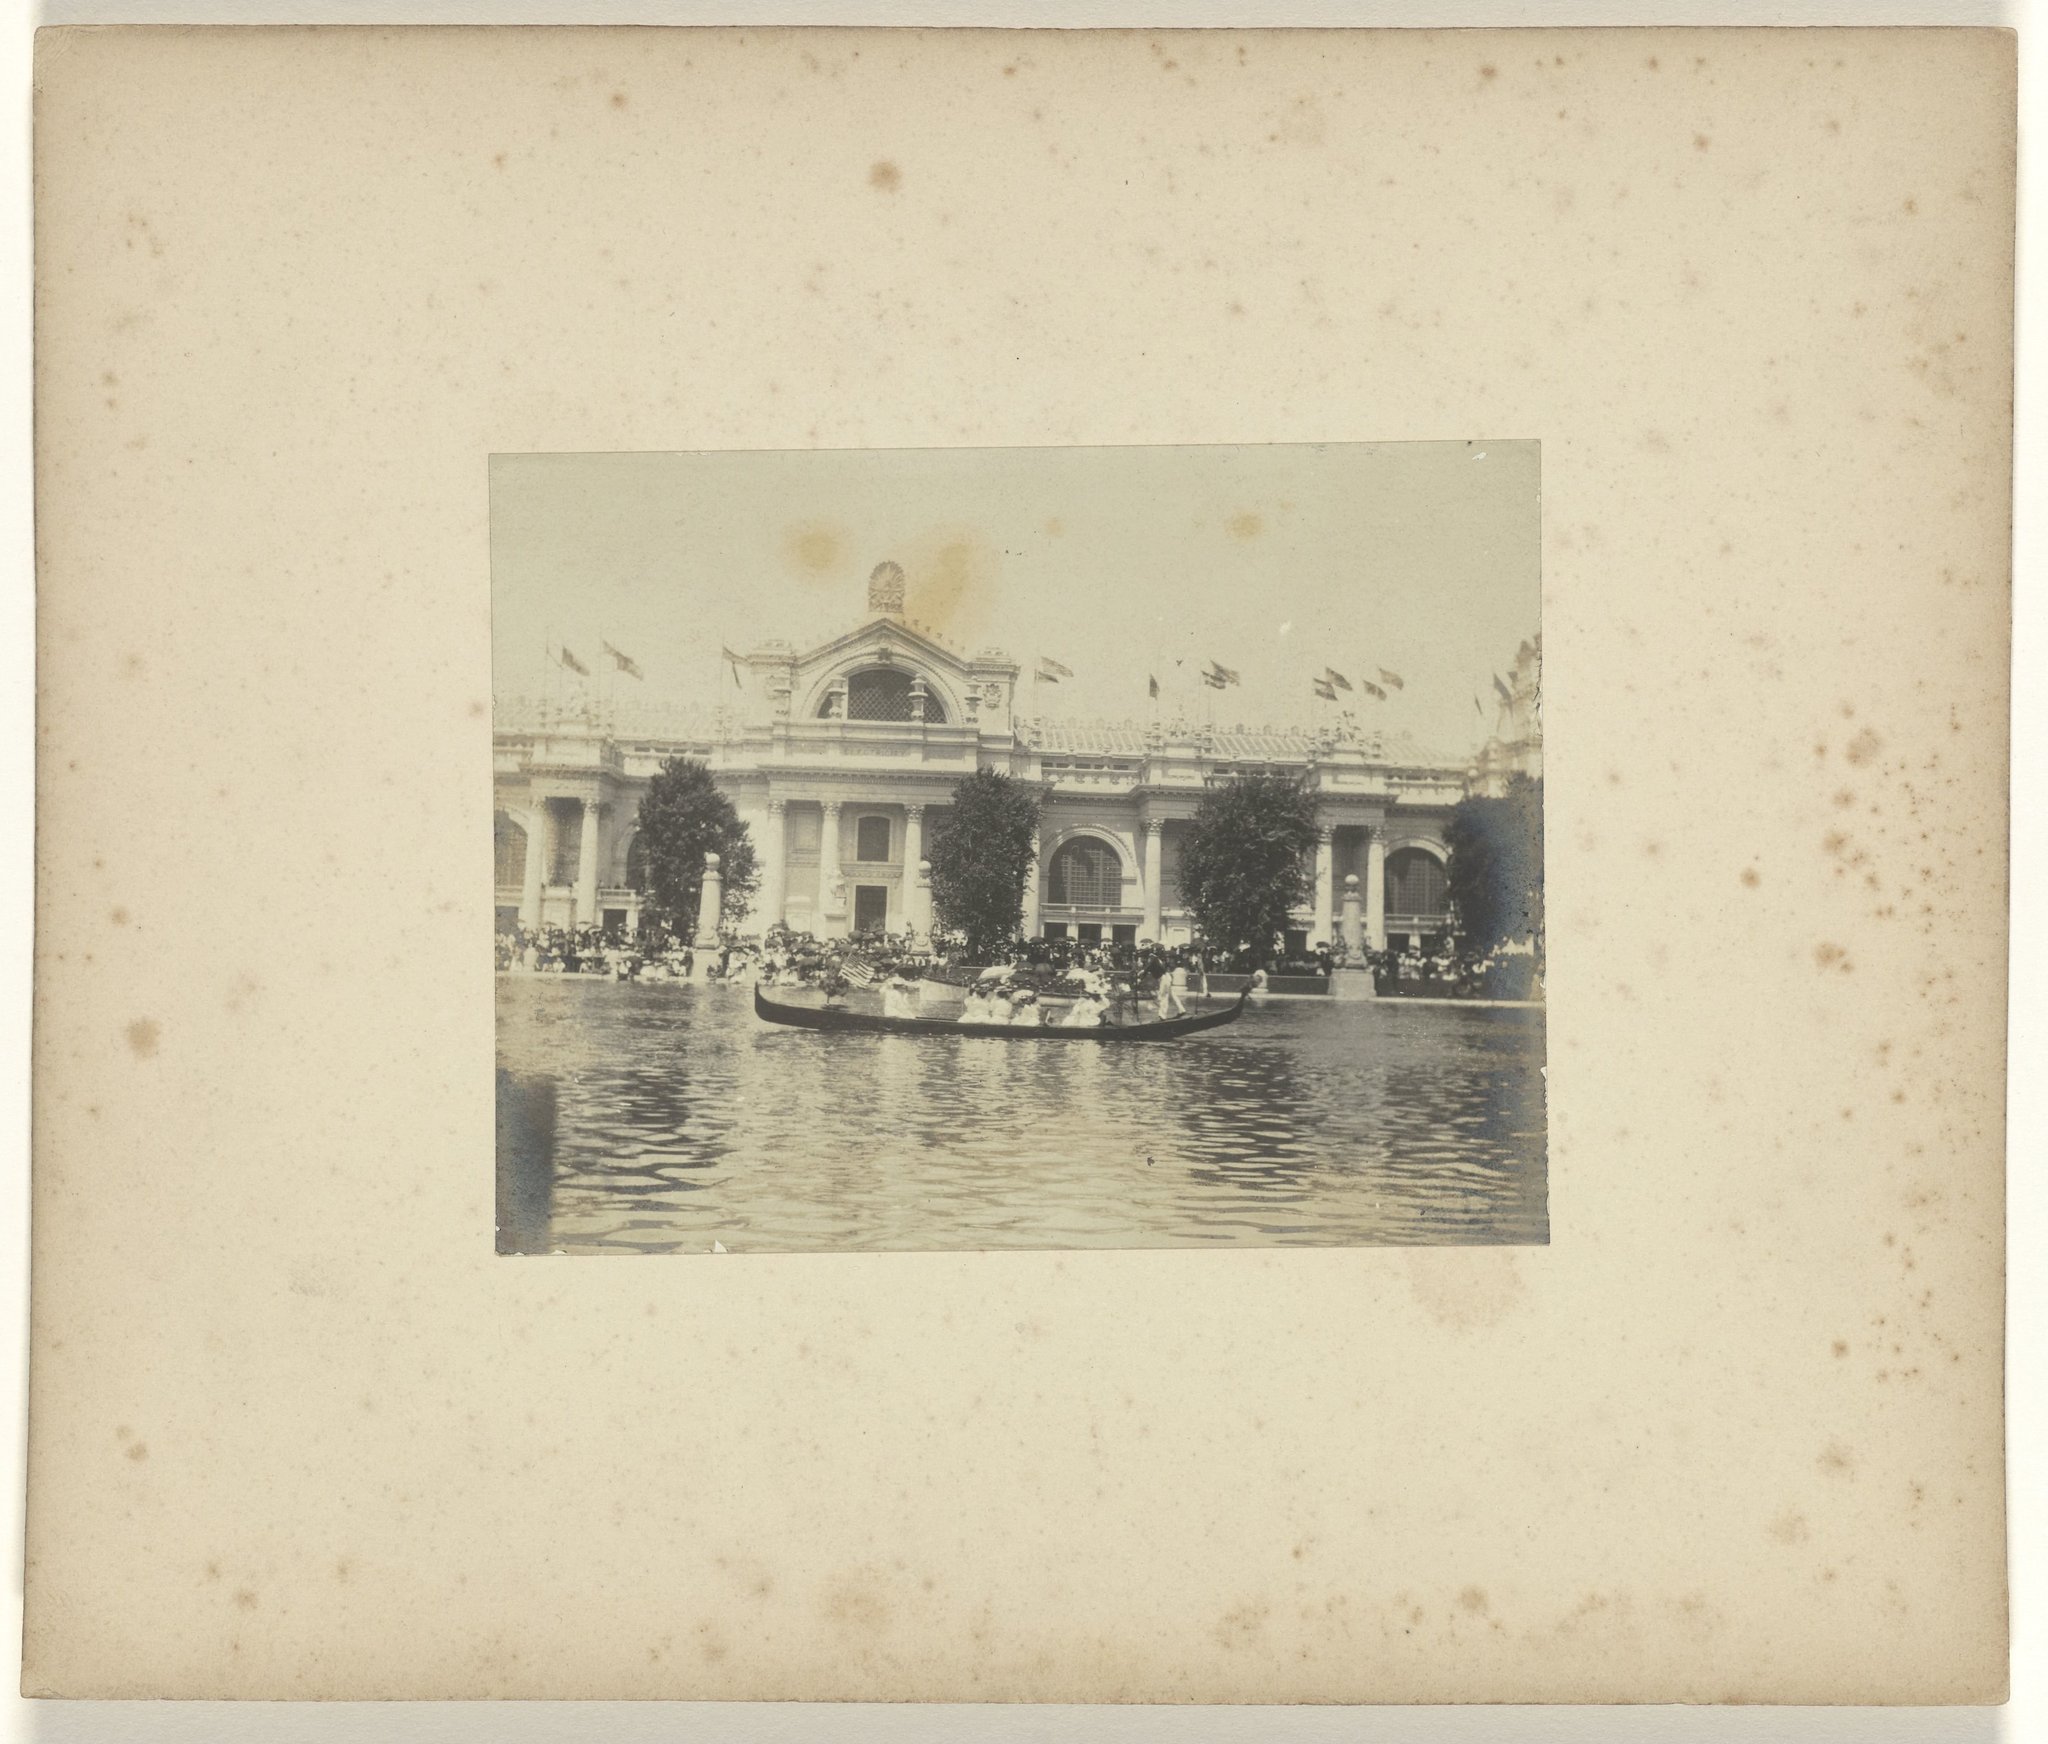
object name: photograph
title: Gondel met vrouwen op de wereldtentoonstelling in St. Louis (Louisiana Purchase Exposition), 1904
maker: jan schüller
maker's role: draughtsman, painter, print maker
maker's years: 1871-1915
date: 1904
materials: cardboard, paper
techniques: gelatin silver print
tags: world fair, world exhibition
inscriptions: annotation: ‘Gondel met dames’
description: Gondel met vrouwen op de wereldtentoonstelling in St. Louis (Louisiana Purchase Exposition), 1904.